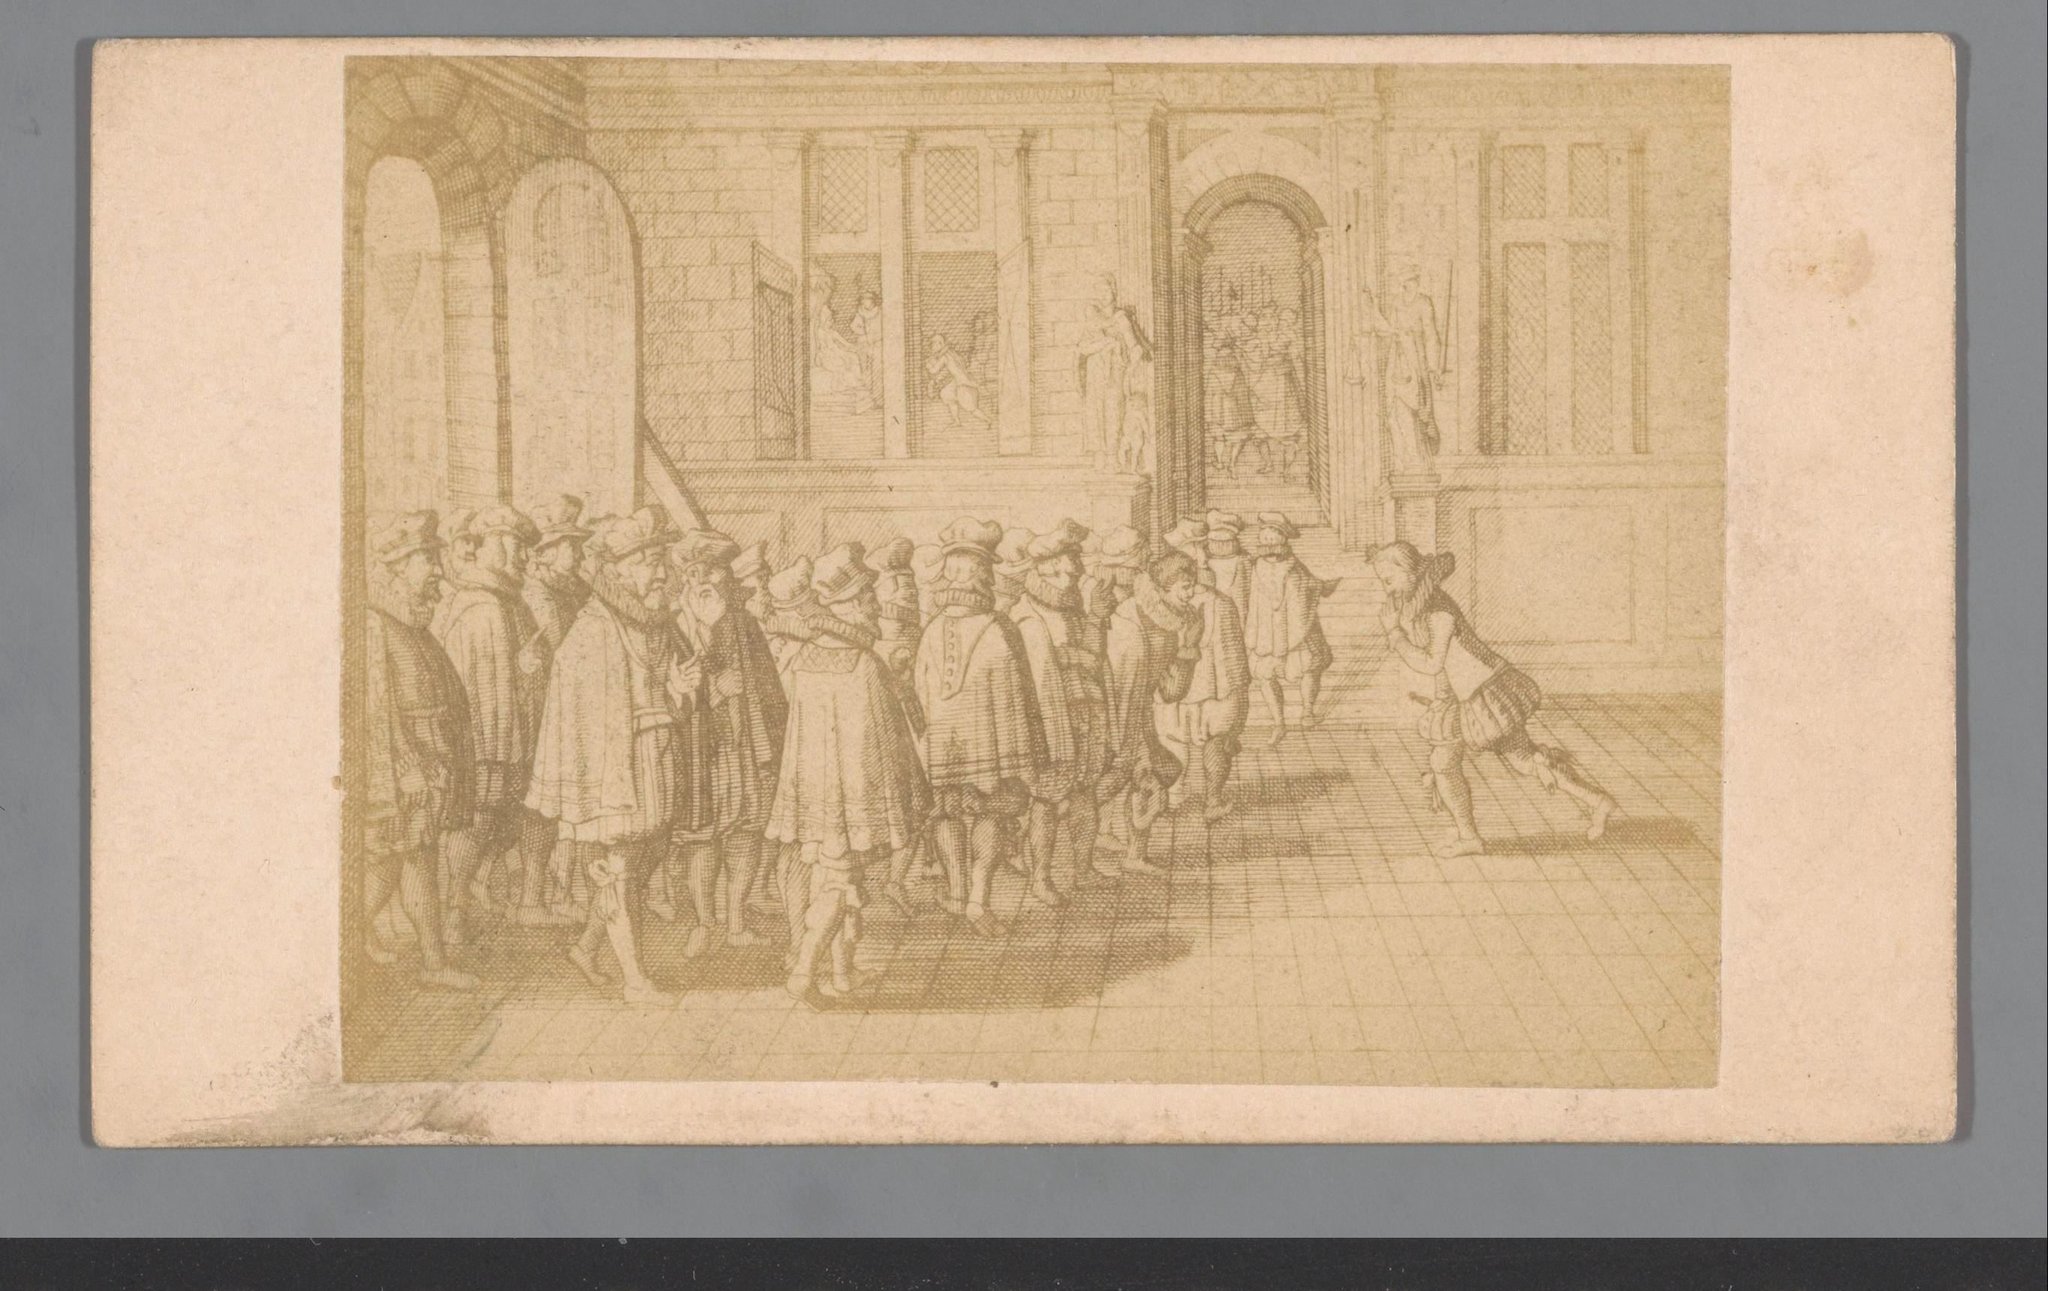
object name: carte de visite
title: Fotoreproductie van een gravure van de aanbieding van een smeekschrift door Nederlandse edelen aan de landvoogdes Margaretha van Parma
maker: Anonymous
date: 1850-1900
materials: cardboard, photographic support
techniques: albumen print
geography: netherlands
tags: audition; ruler giving audience - bb - female ruler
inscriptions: inscription: ‘Het Smeekschrift (...) la besace.’, number: ‘3/ 1566’